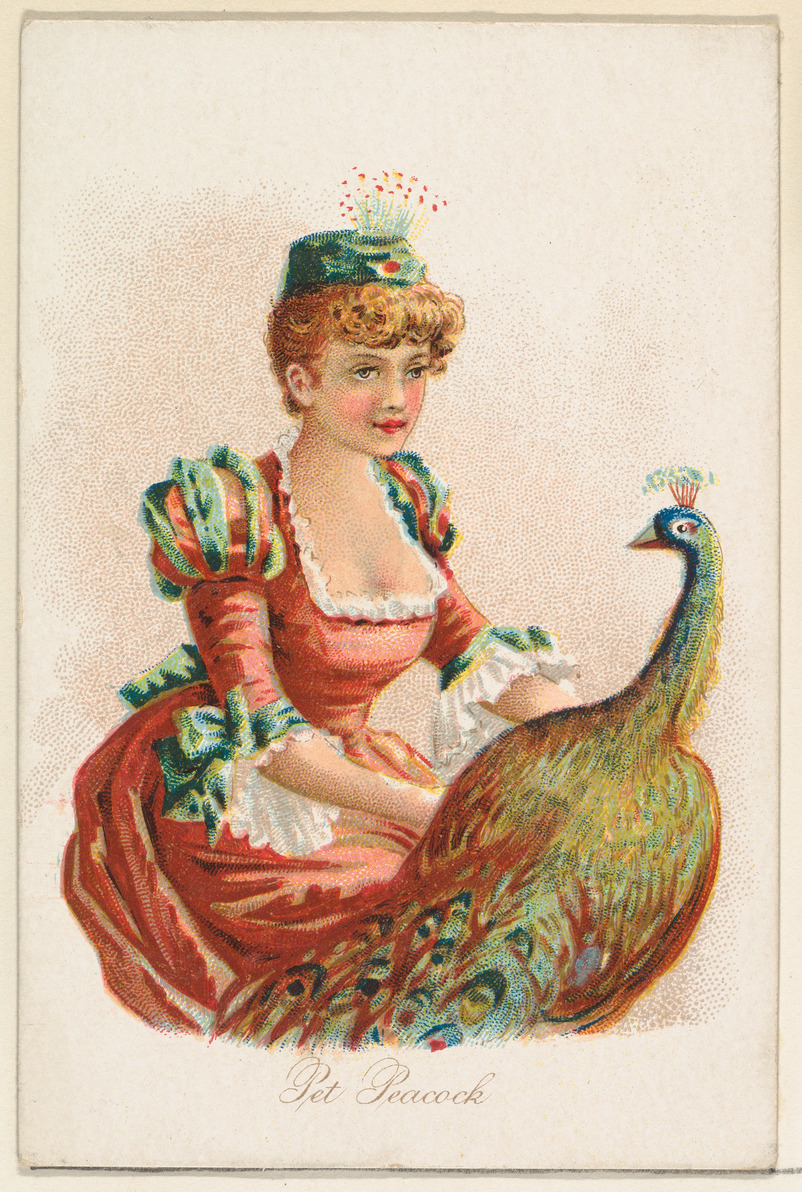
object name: print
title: Pet Peacock, from the Household Pets series (N194) issued by Wm. S. Kimball & Co.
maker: william s. kimball & company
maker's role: publisher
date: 1891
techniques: color lithograph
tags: women,peacocks